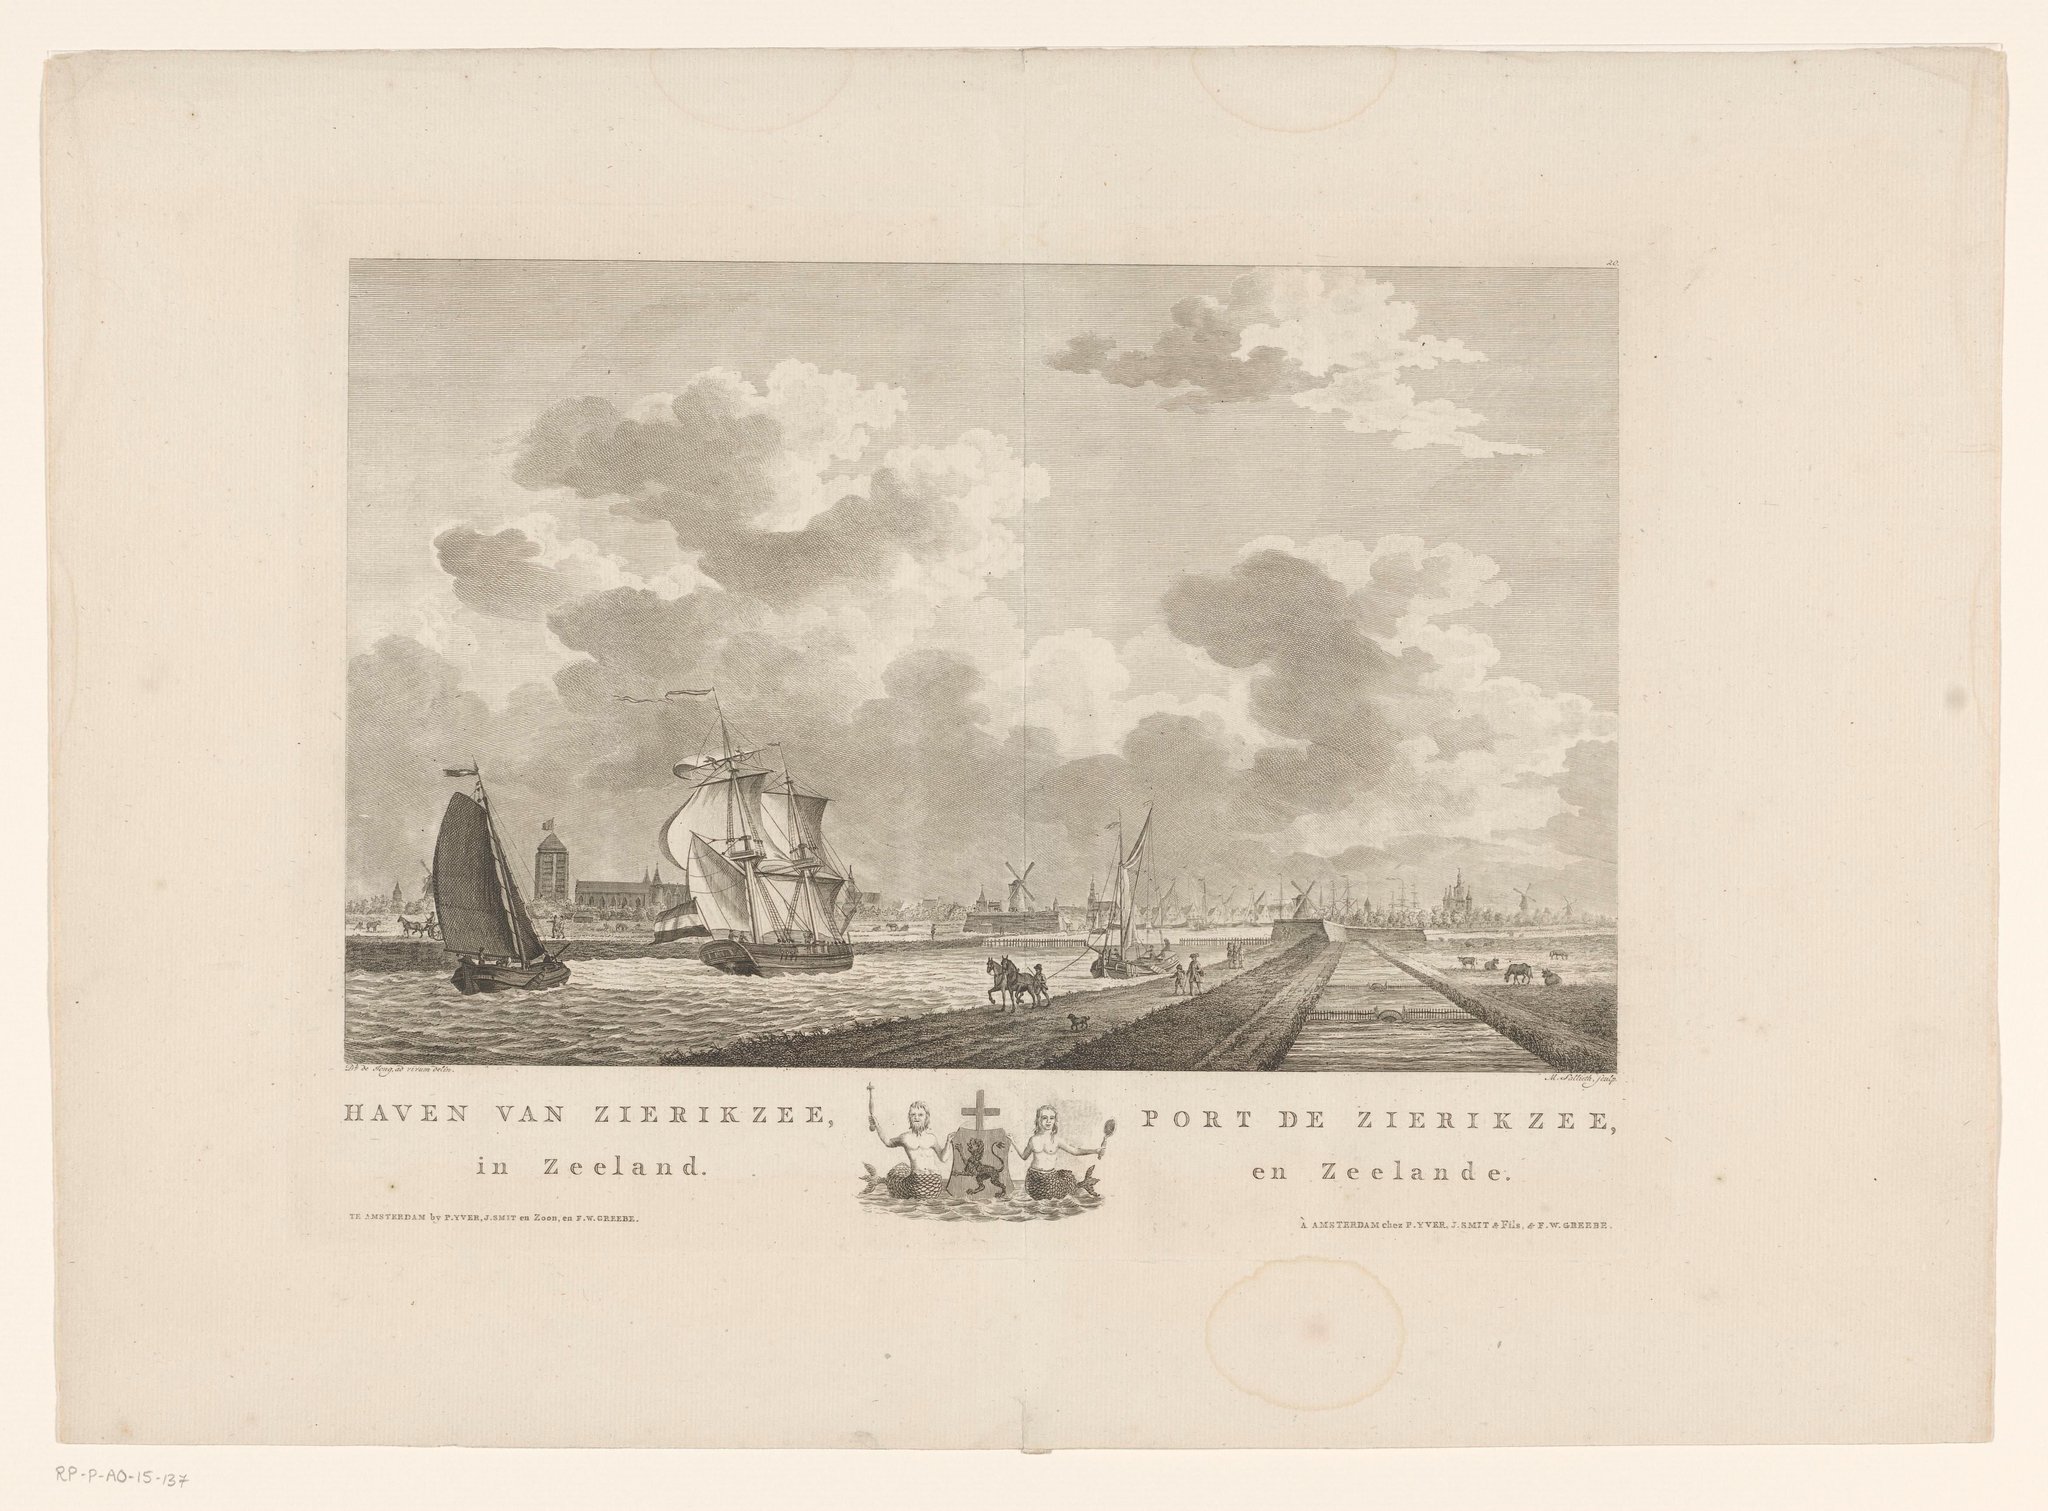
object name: print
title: Haven van Zierikzee, in Zeeland / Port de Zierikzee, en Zeelande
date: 1779-1787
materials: paper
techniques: engraving, etching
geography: amsterdam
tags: harbour, coat of arms (as symbol of the state, etc.) (+ city; municipal), sailing-ship, sailing-boat, church (exterior)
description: Latere staat ook gebruikt in: Aa, Cornelis van der. Atlas van de zeehavens der Bataafsche Republiek. Met derzelver beschrijvingen in XXXI kunstplaaten / Atlas van de zeehavens der Bataafsche Republiek, die van Batavia en Onrust. Mitsgaders de afbeeldingen van de haringvisscherij en de walvischvangst (…). Amsterdam: Evert Maaskamp, 1805.